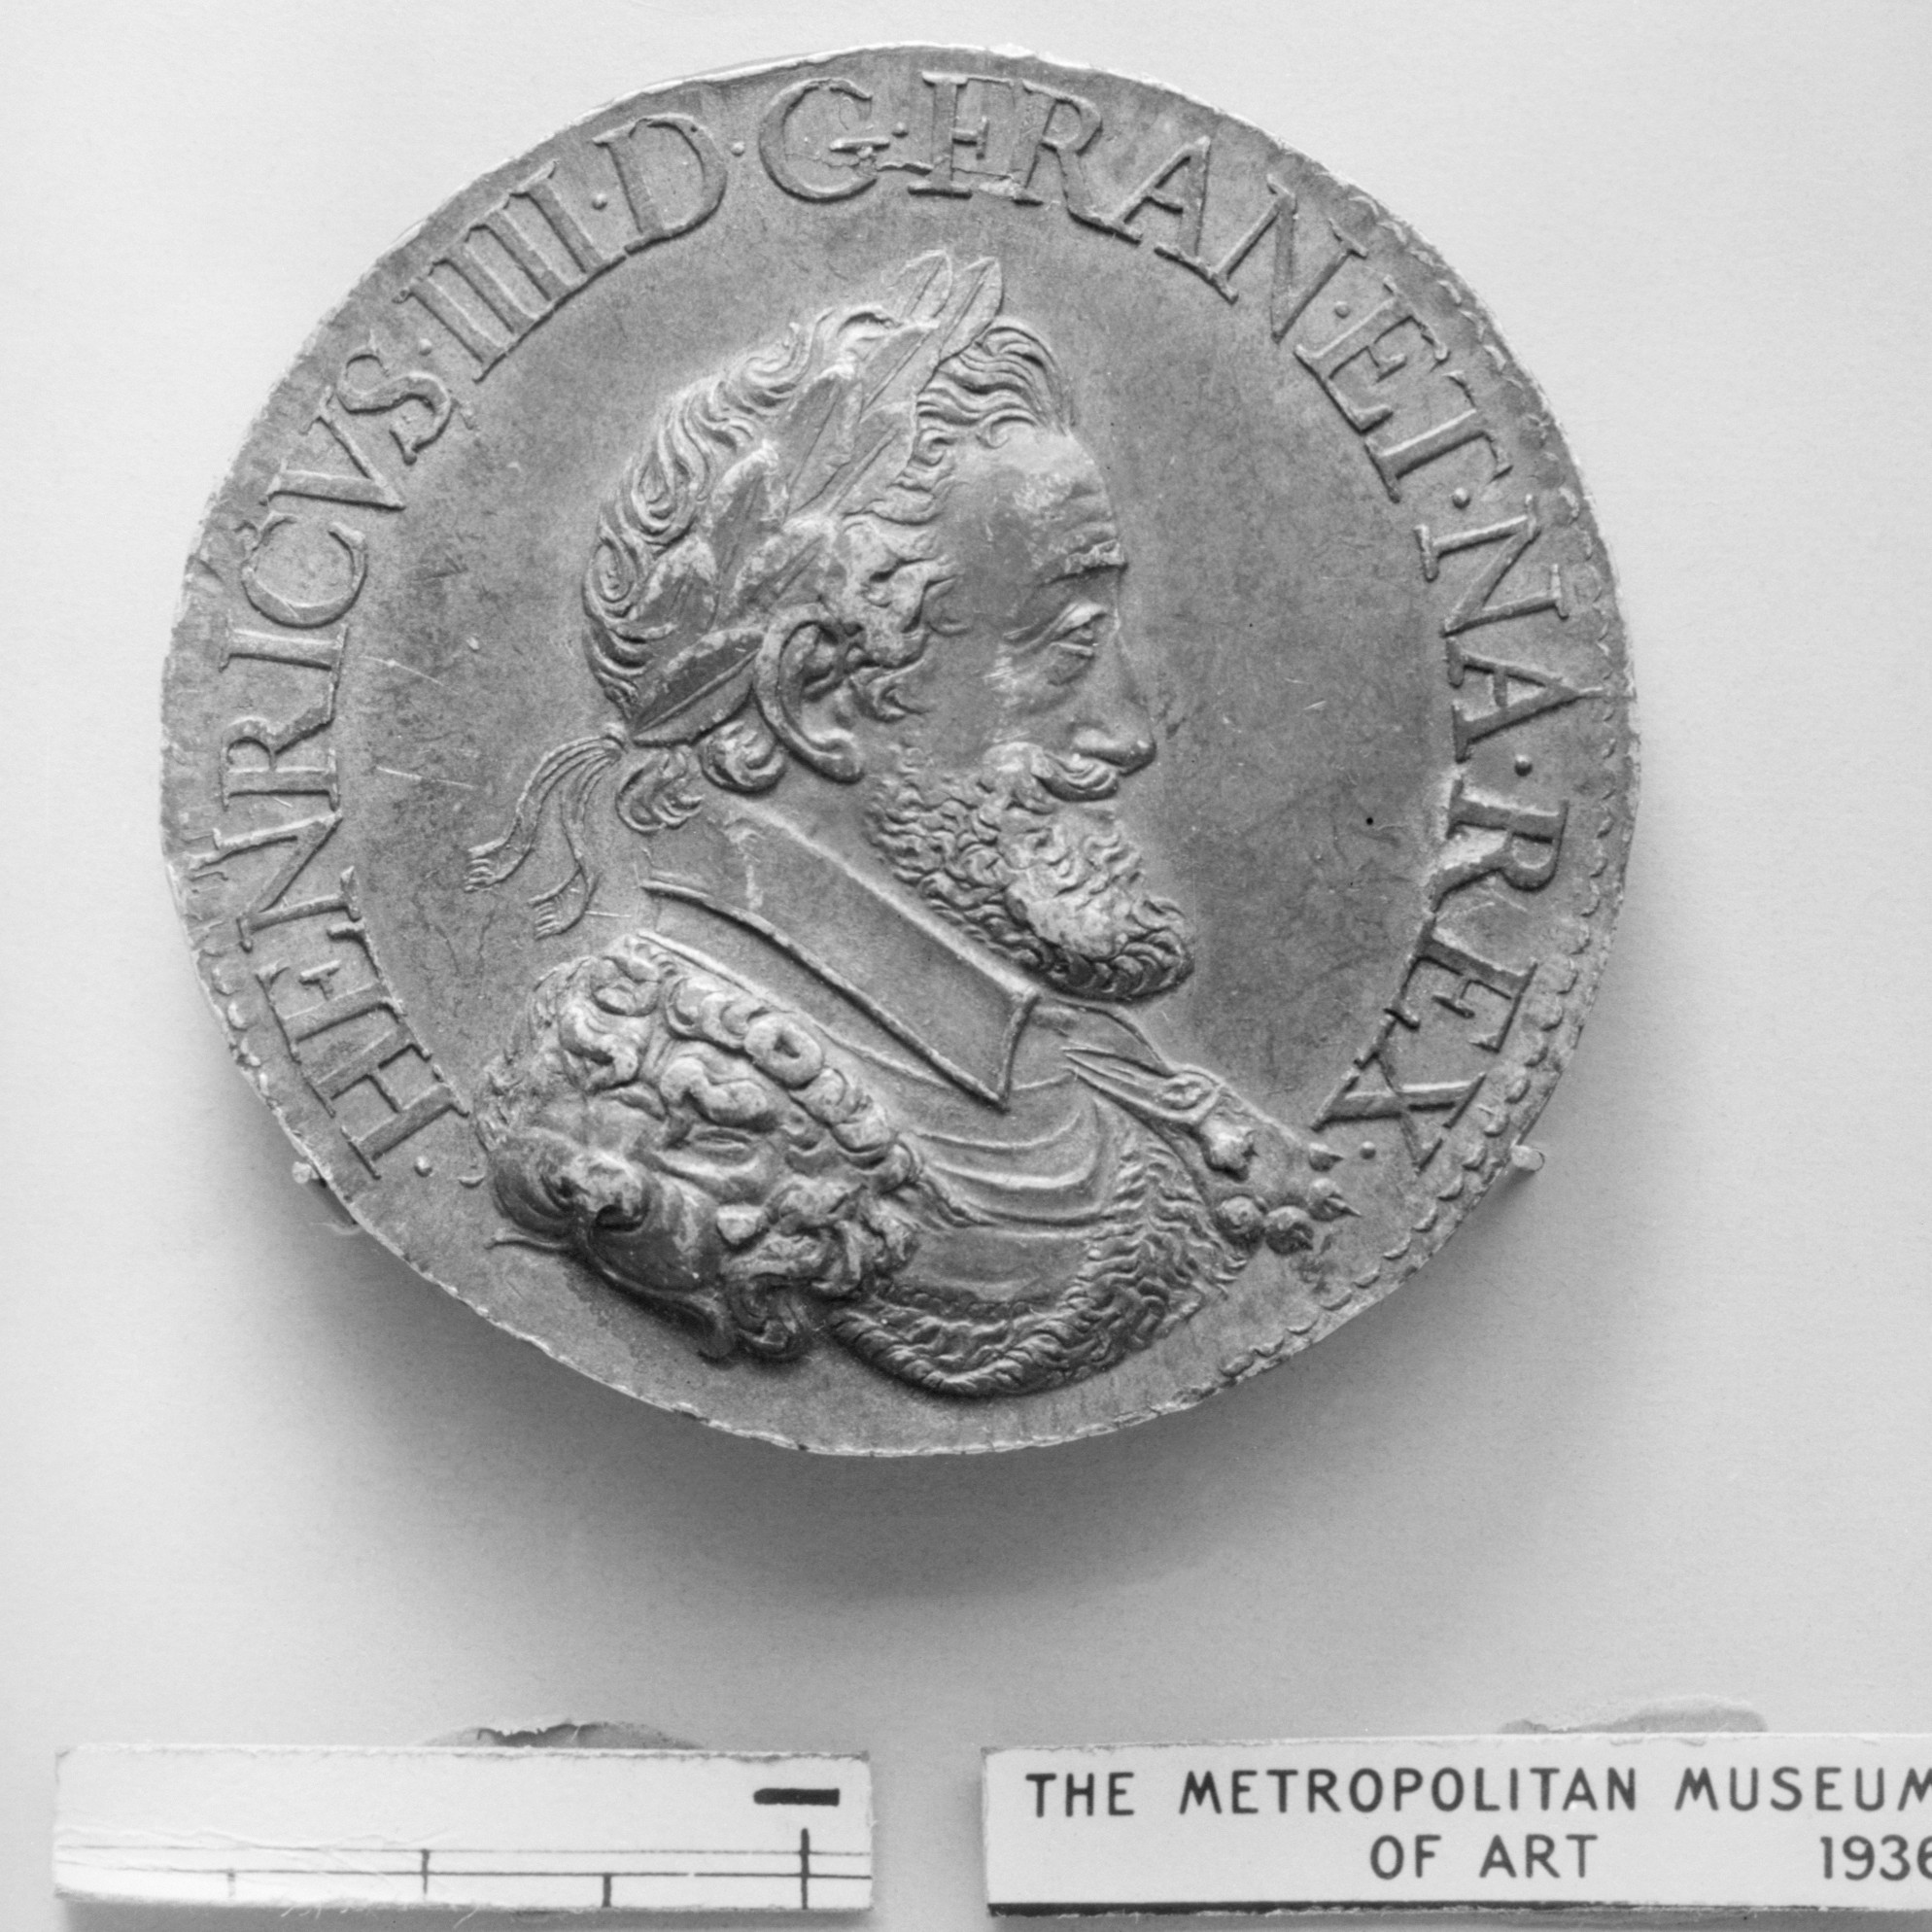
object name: medal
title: Henry IV of France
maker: philippe danfrie the elder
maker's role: artist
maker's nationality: french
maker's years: 1531-1606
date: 1590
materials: lead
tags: men,profiles